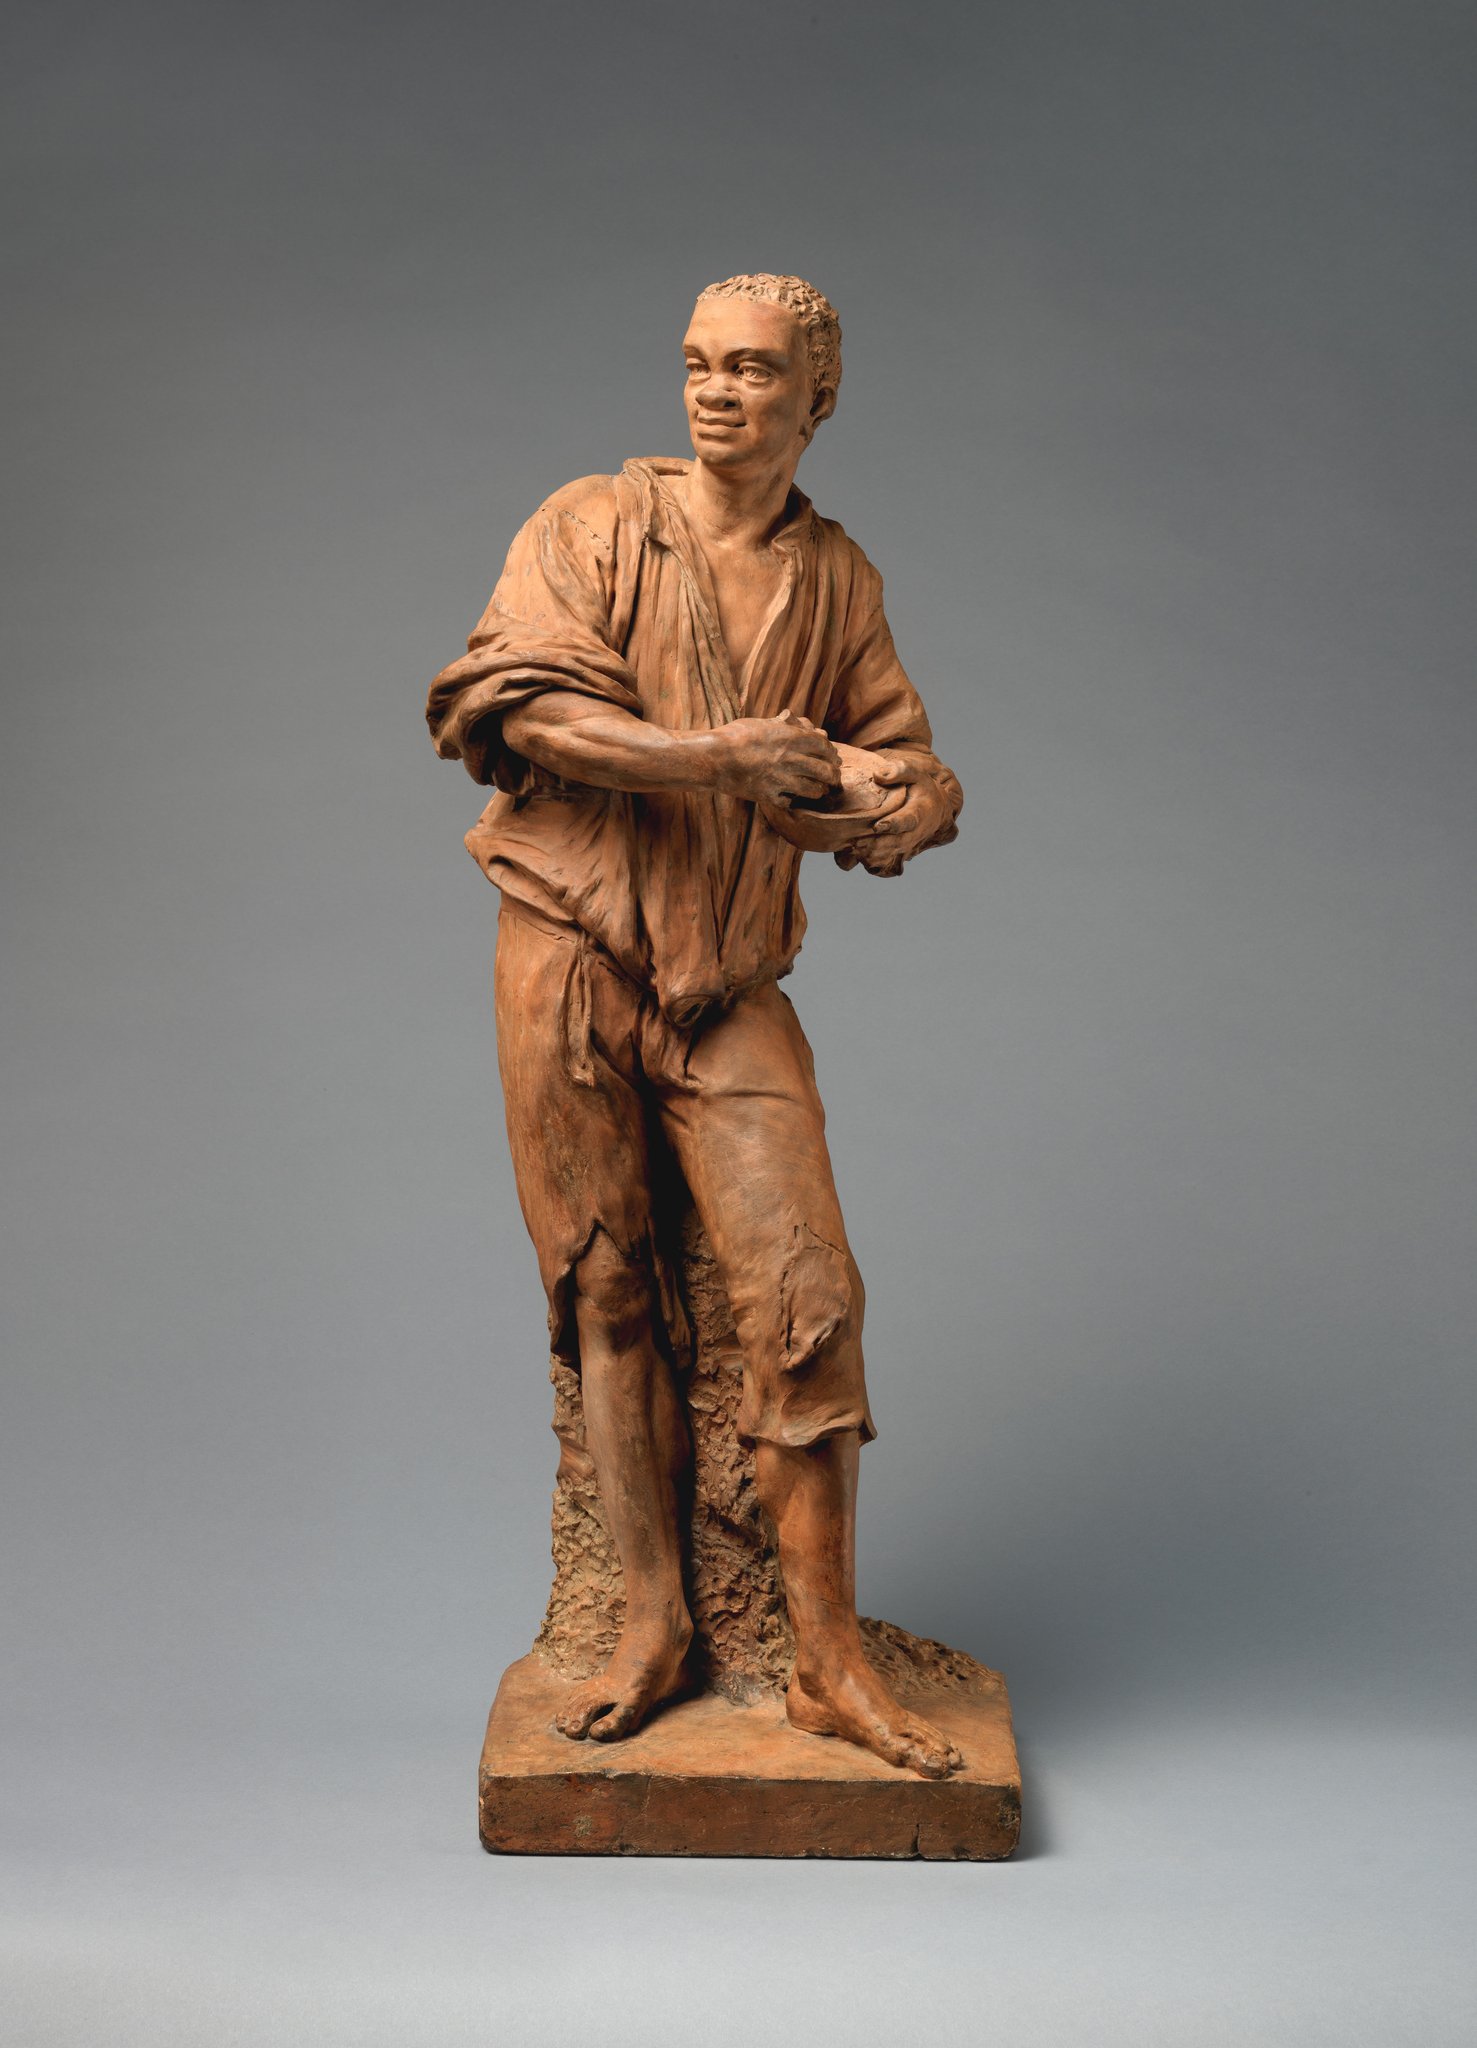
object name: figure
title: Man with a Mixing Bowl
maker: joseph willems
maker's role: artist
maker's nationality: flemish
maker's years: 1716-1766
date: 1736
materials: terracotta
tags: men